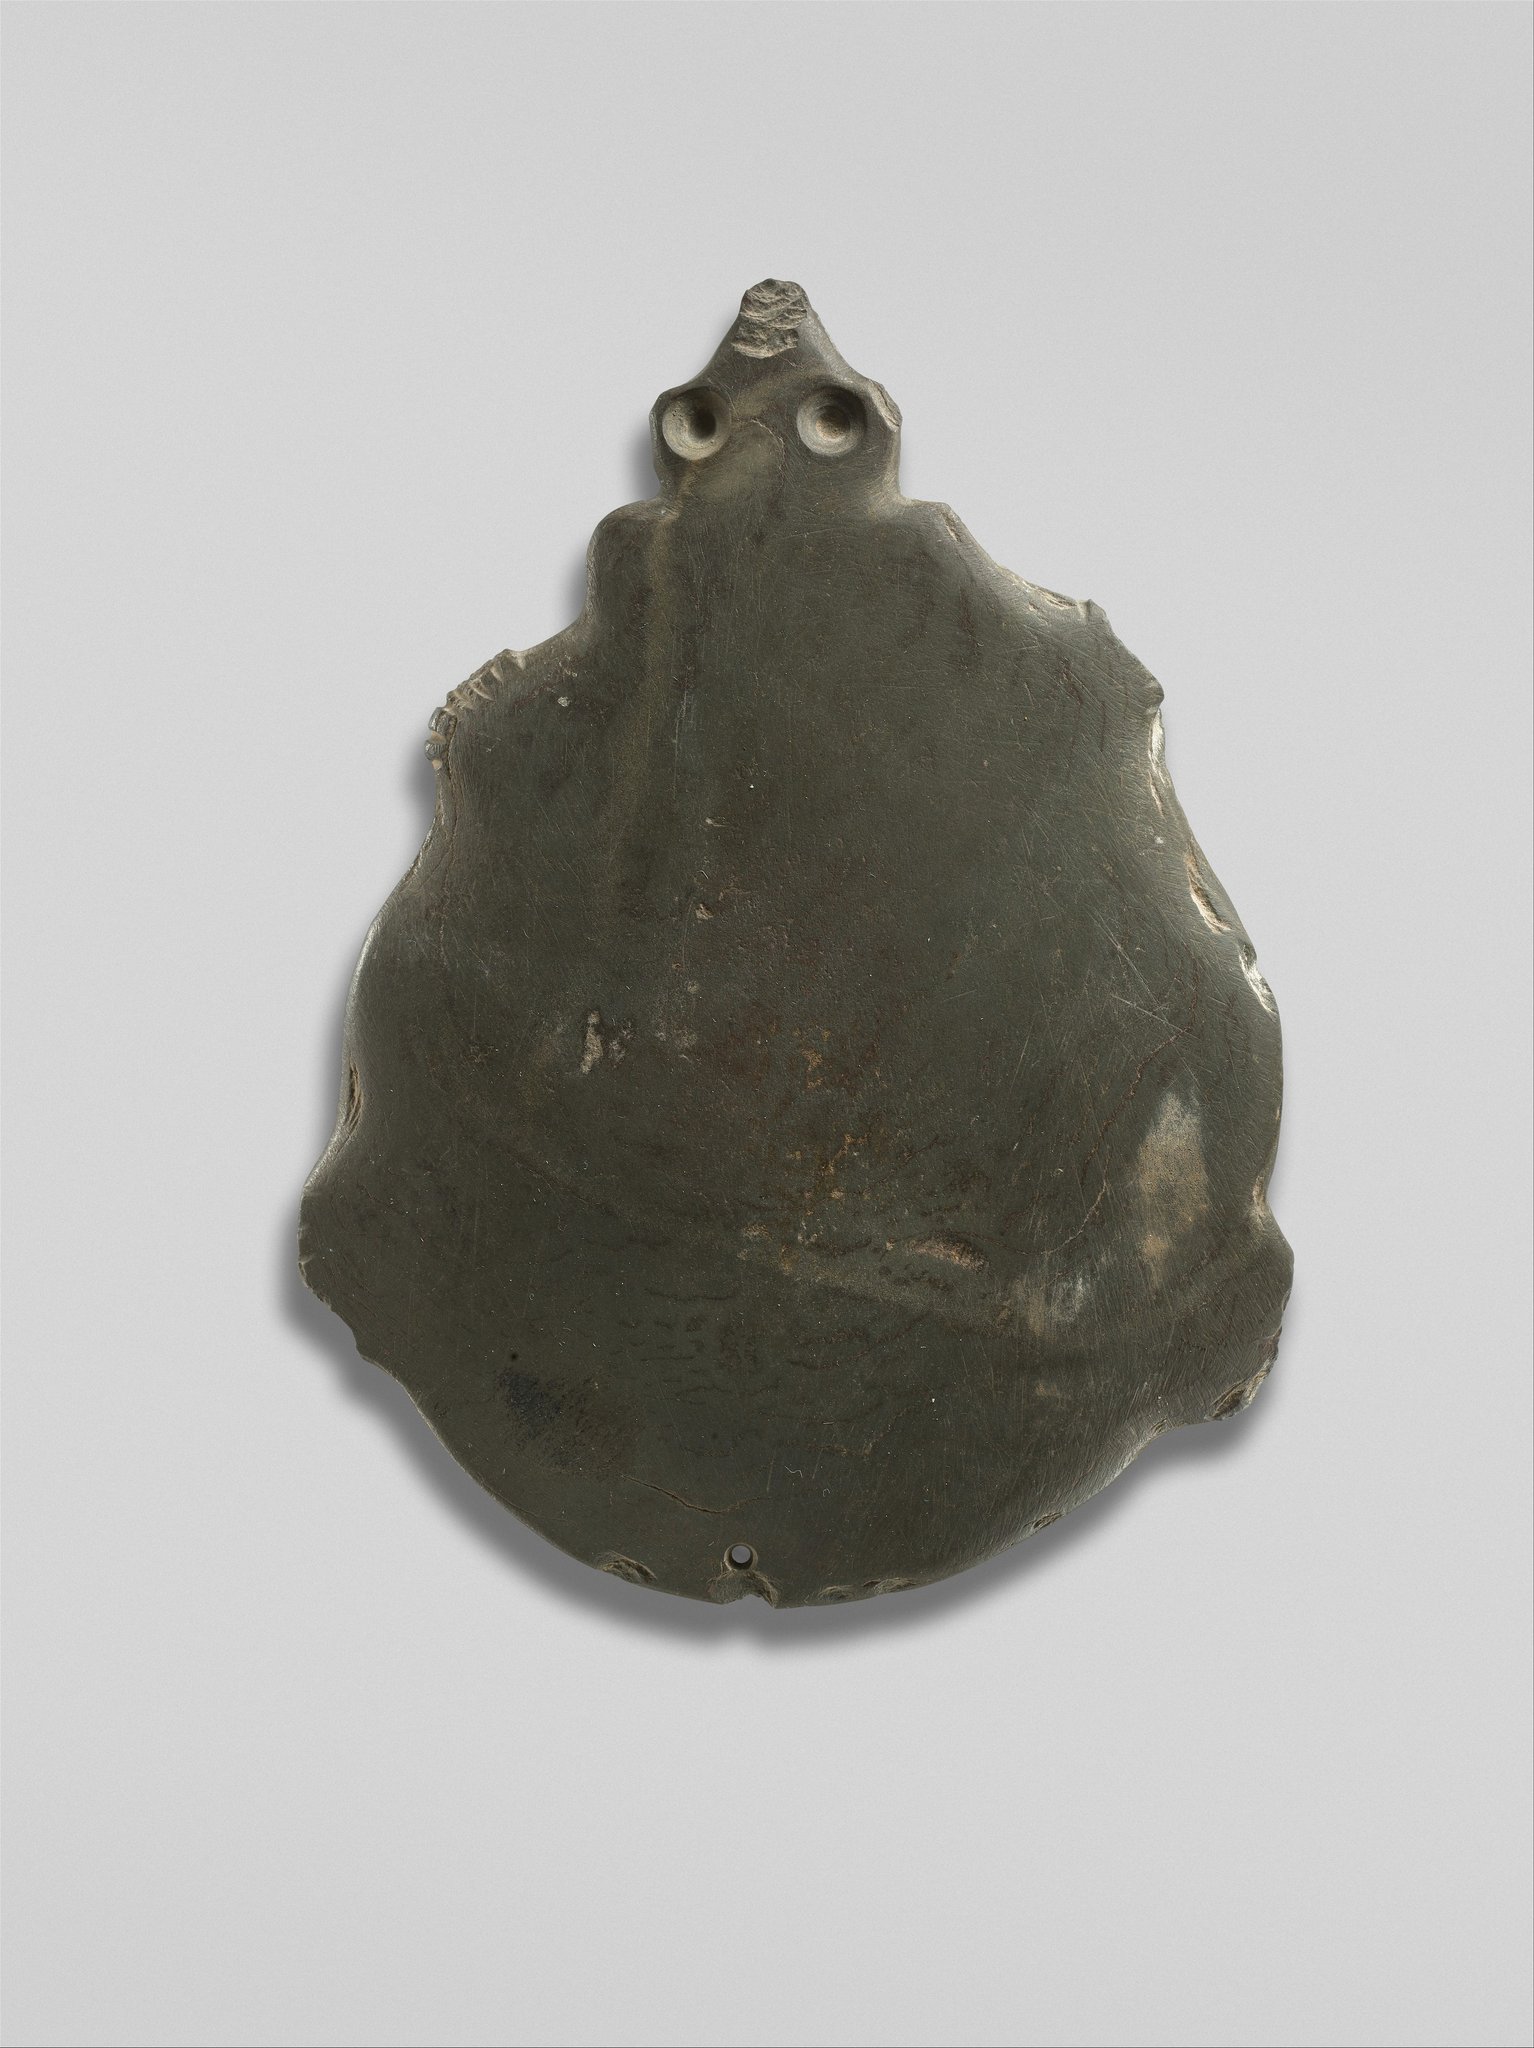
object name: palette, mud turtle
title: Palette in the form of a mud turtle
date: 3650-3500 BCE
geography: egypt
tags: turtles